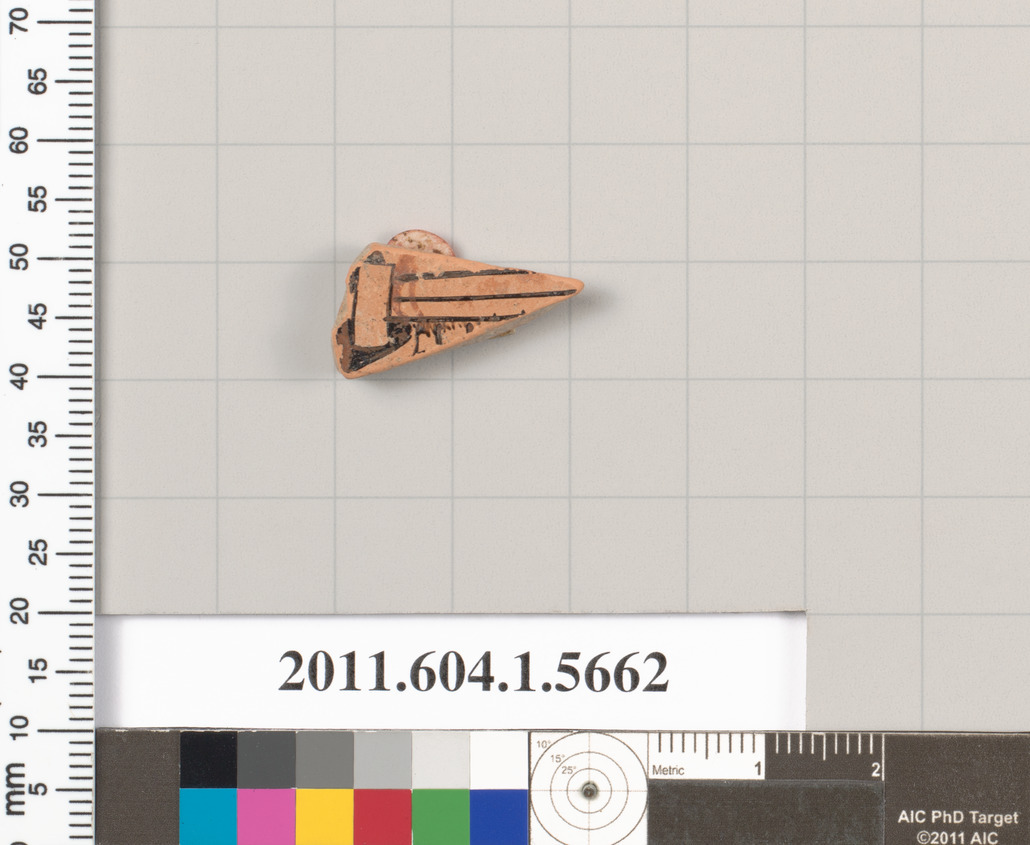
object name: kylix fragment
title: Terracotta fragment of a kylix (drinking cup)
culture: greek, attic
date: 500-480 BCE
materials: terracotta